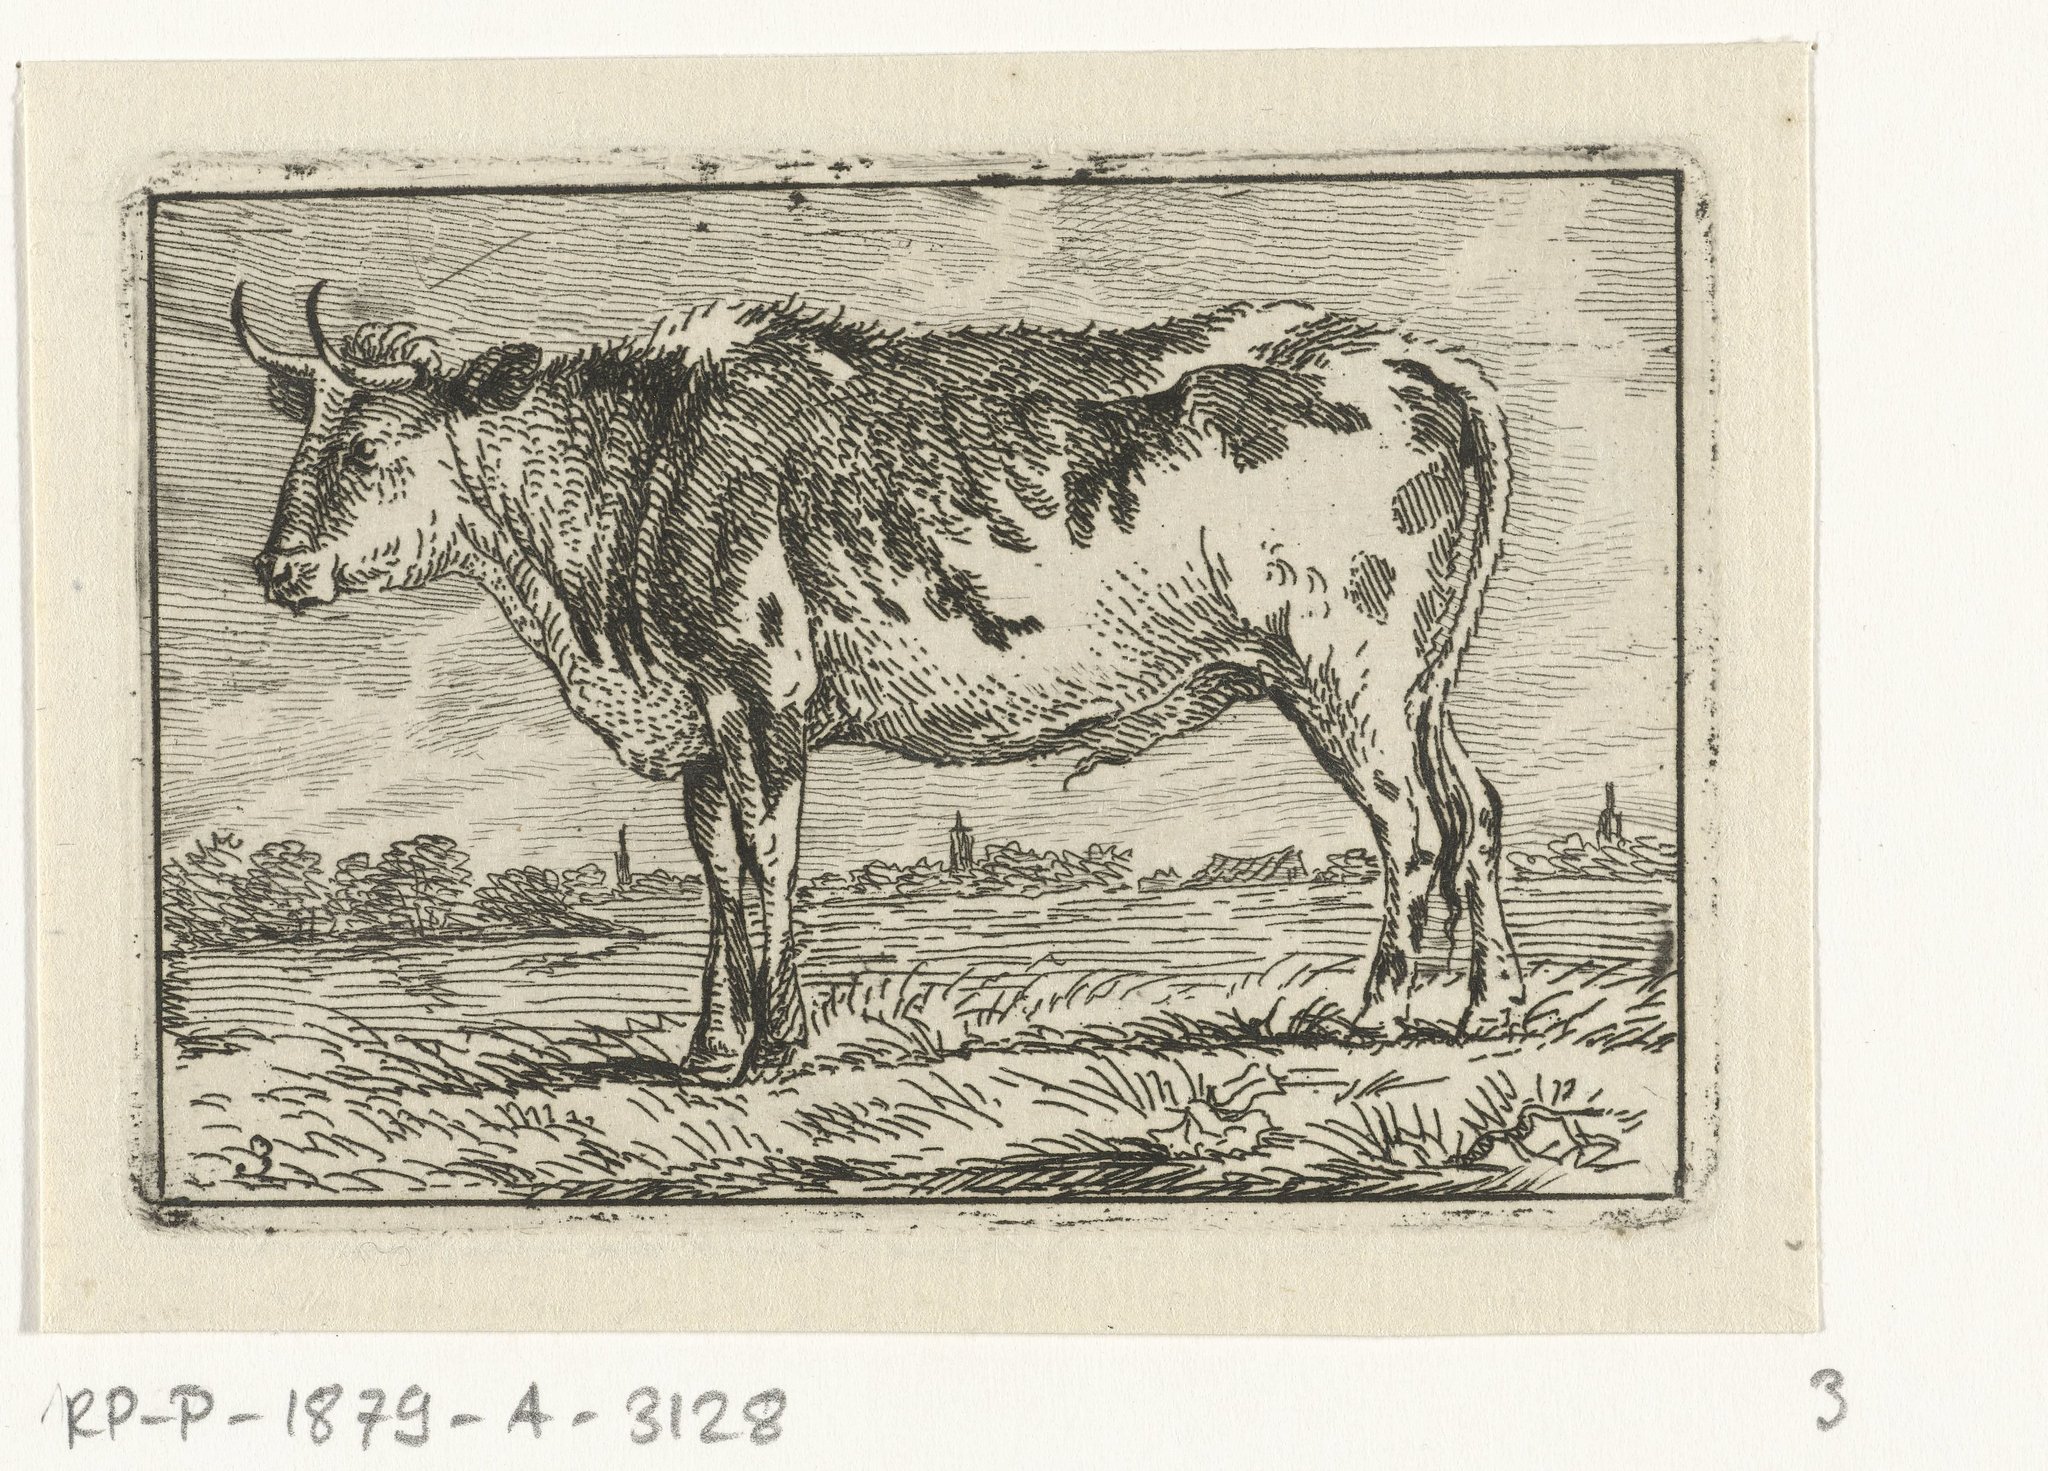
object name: print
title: Koeien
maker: anthony oberman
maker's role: draughtsman, painter, print maker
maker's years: 1781-1845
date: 1796-1845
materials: paper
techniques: etching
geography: amsterdam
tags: bovine cattle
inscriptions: collector's mark: Lugt 2228